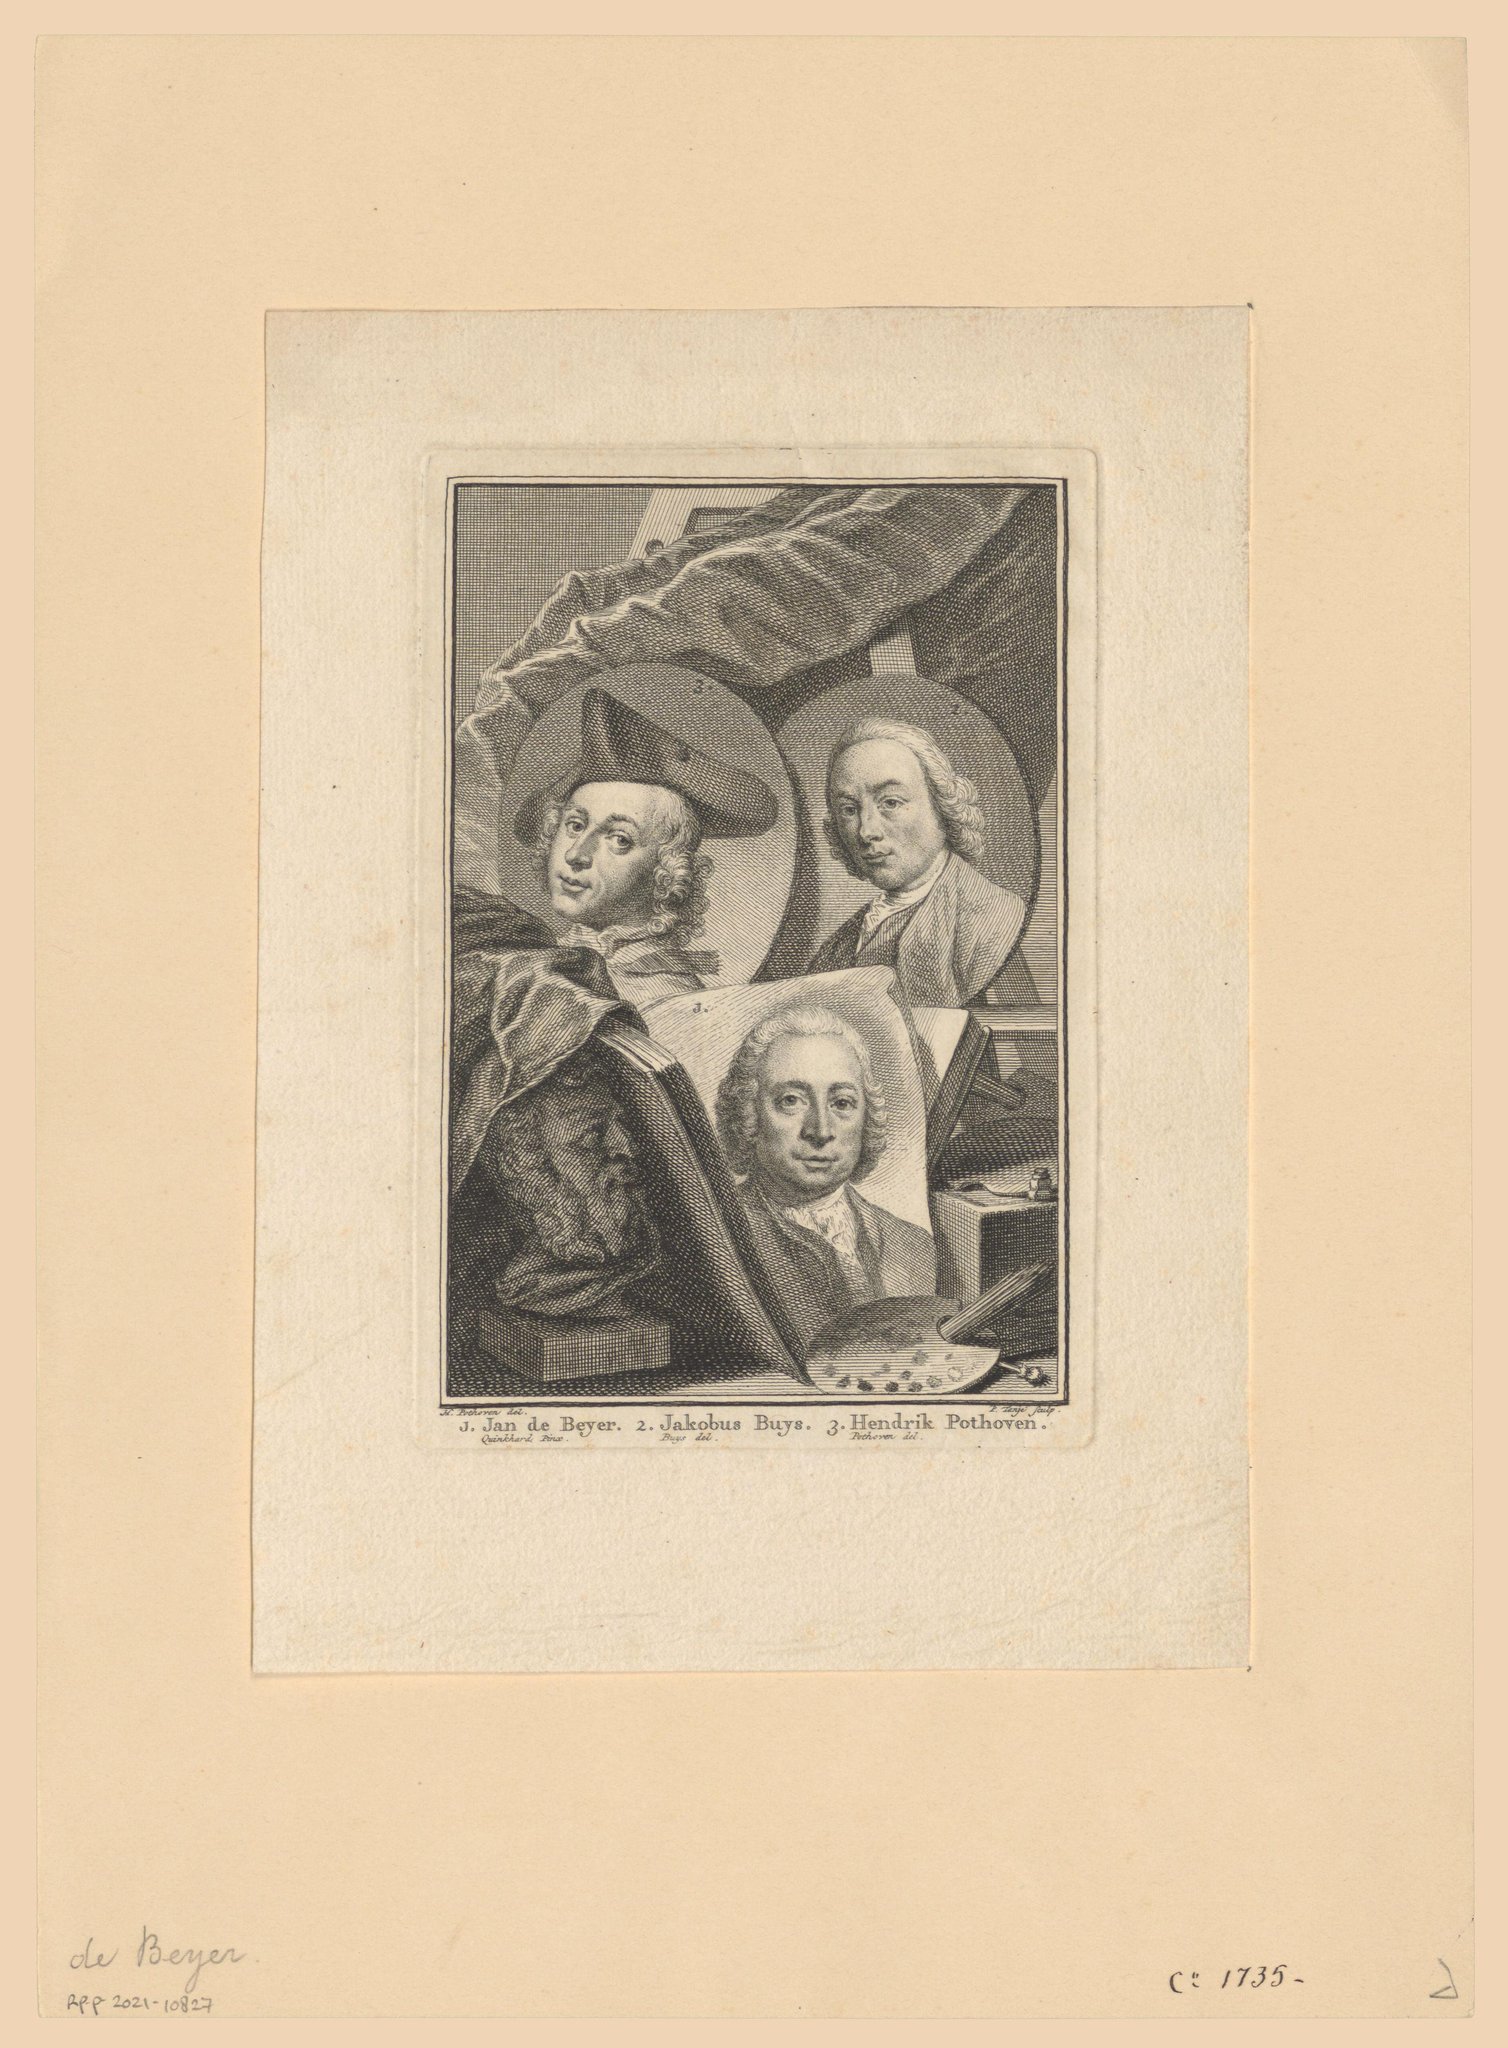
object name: print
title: Portretten van Jan de Beijer, Jacobus Buys en Hendrik Pothoven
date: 1751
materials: paper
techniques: engraving, etching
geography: amsterdam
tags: print maker, jan de beijer, the hague, painter, hendrik pothoven, jacobus buys, adult man, historical persons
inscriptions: inscription: ‘Deze portretten zijn hoogst-/ waarschijnlijk voor het [...]/ v. Gool gegraveerd maar niet/ gebruikt’ Lugt 963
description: Drie genummerde portretten van de schilders Jan de Beijer, Jacobus Buys en Hendrik Pothoven. Links een gebeeldhouwd mannenhoofd. Rechtsonder een palet en penselen.